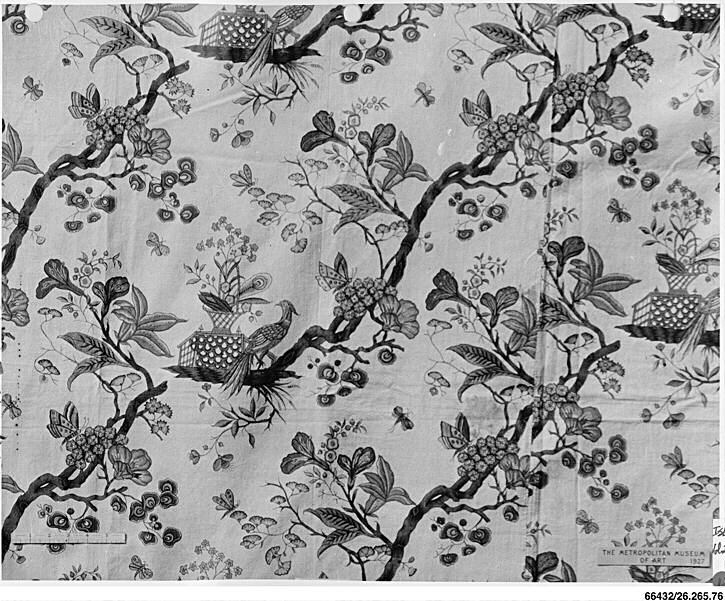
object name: panel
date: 1775-1785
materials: cotton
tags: birds,flowers,leaves